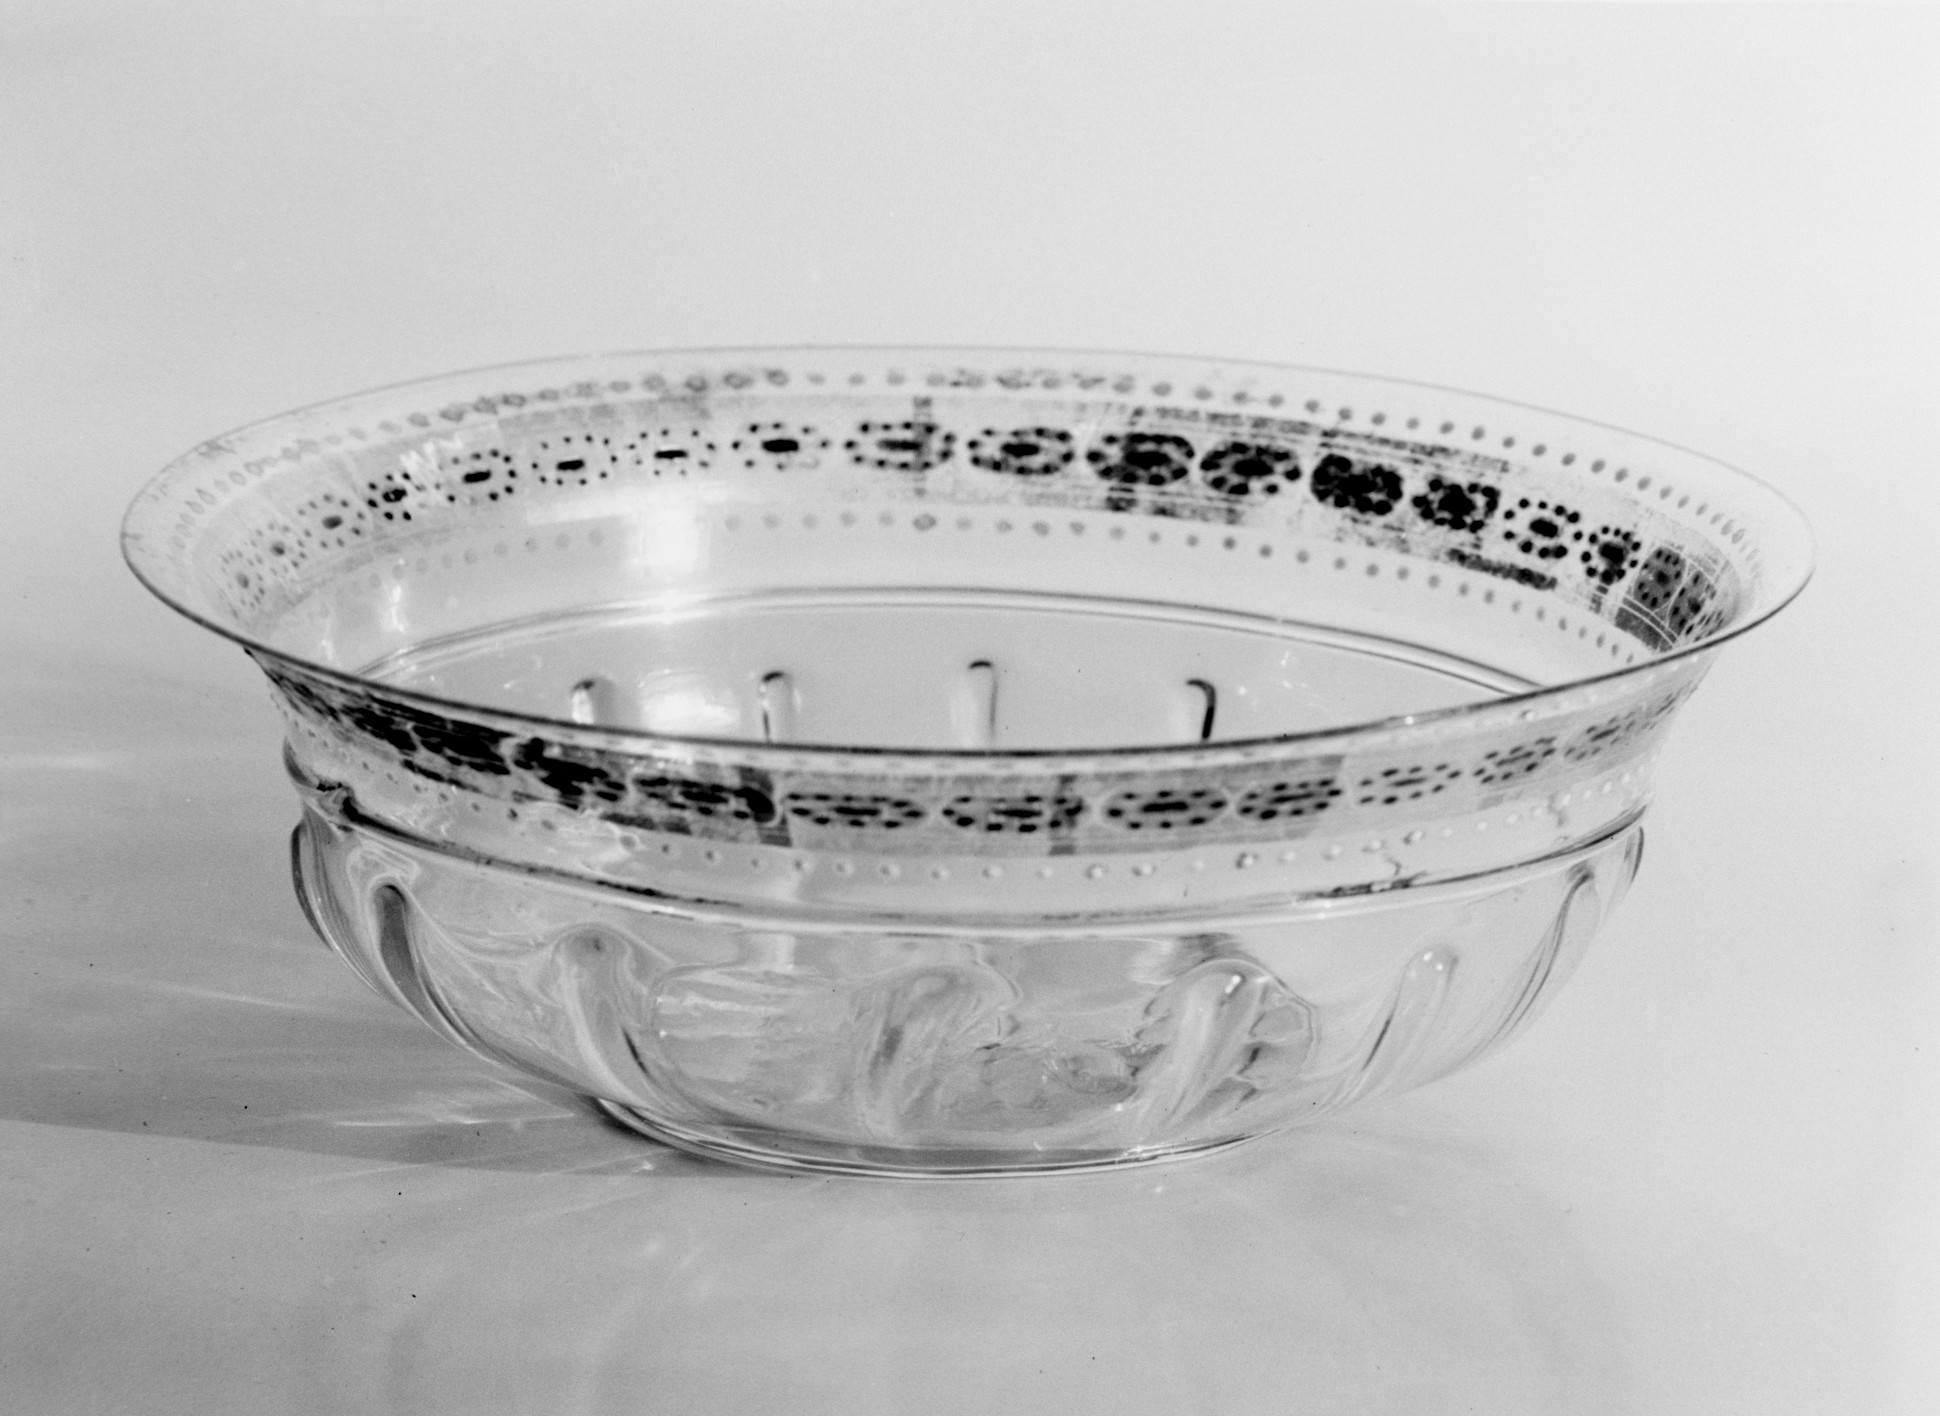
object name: bowl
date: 1501-1600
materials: glass